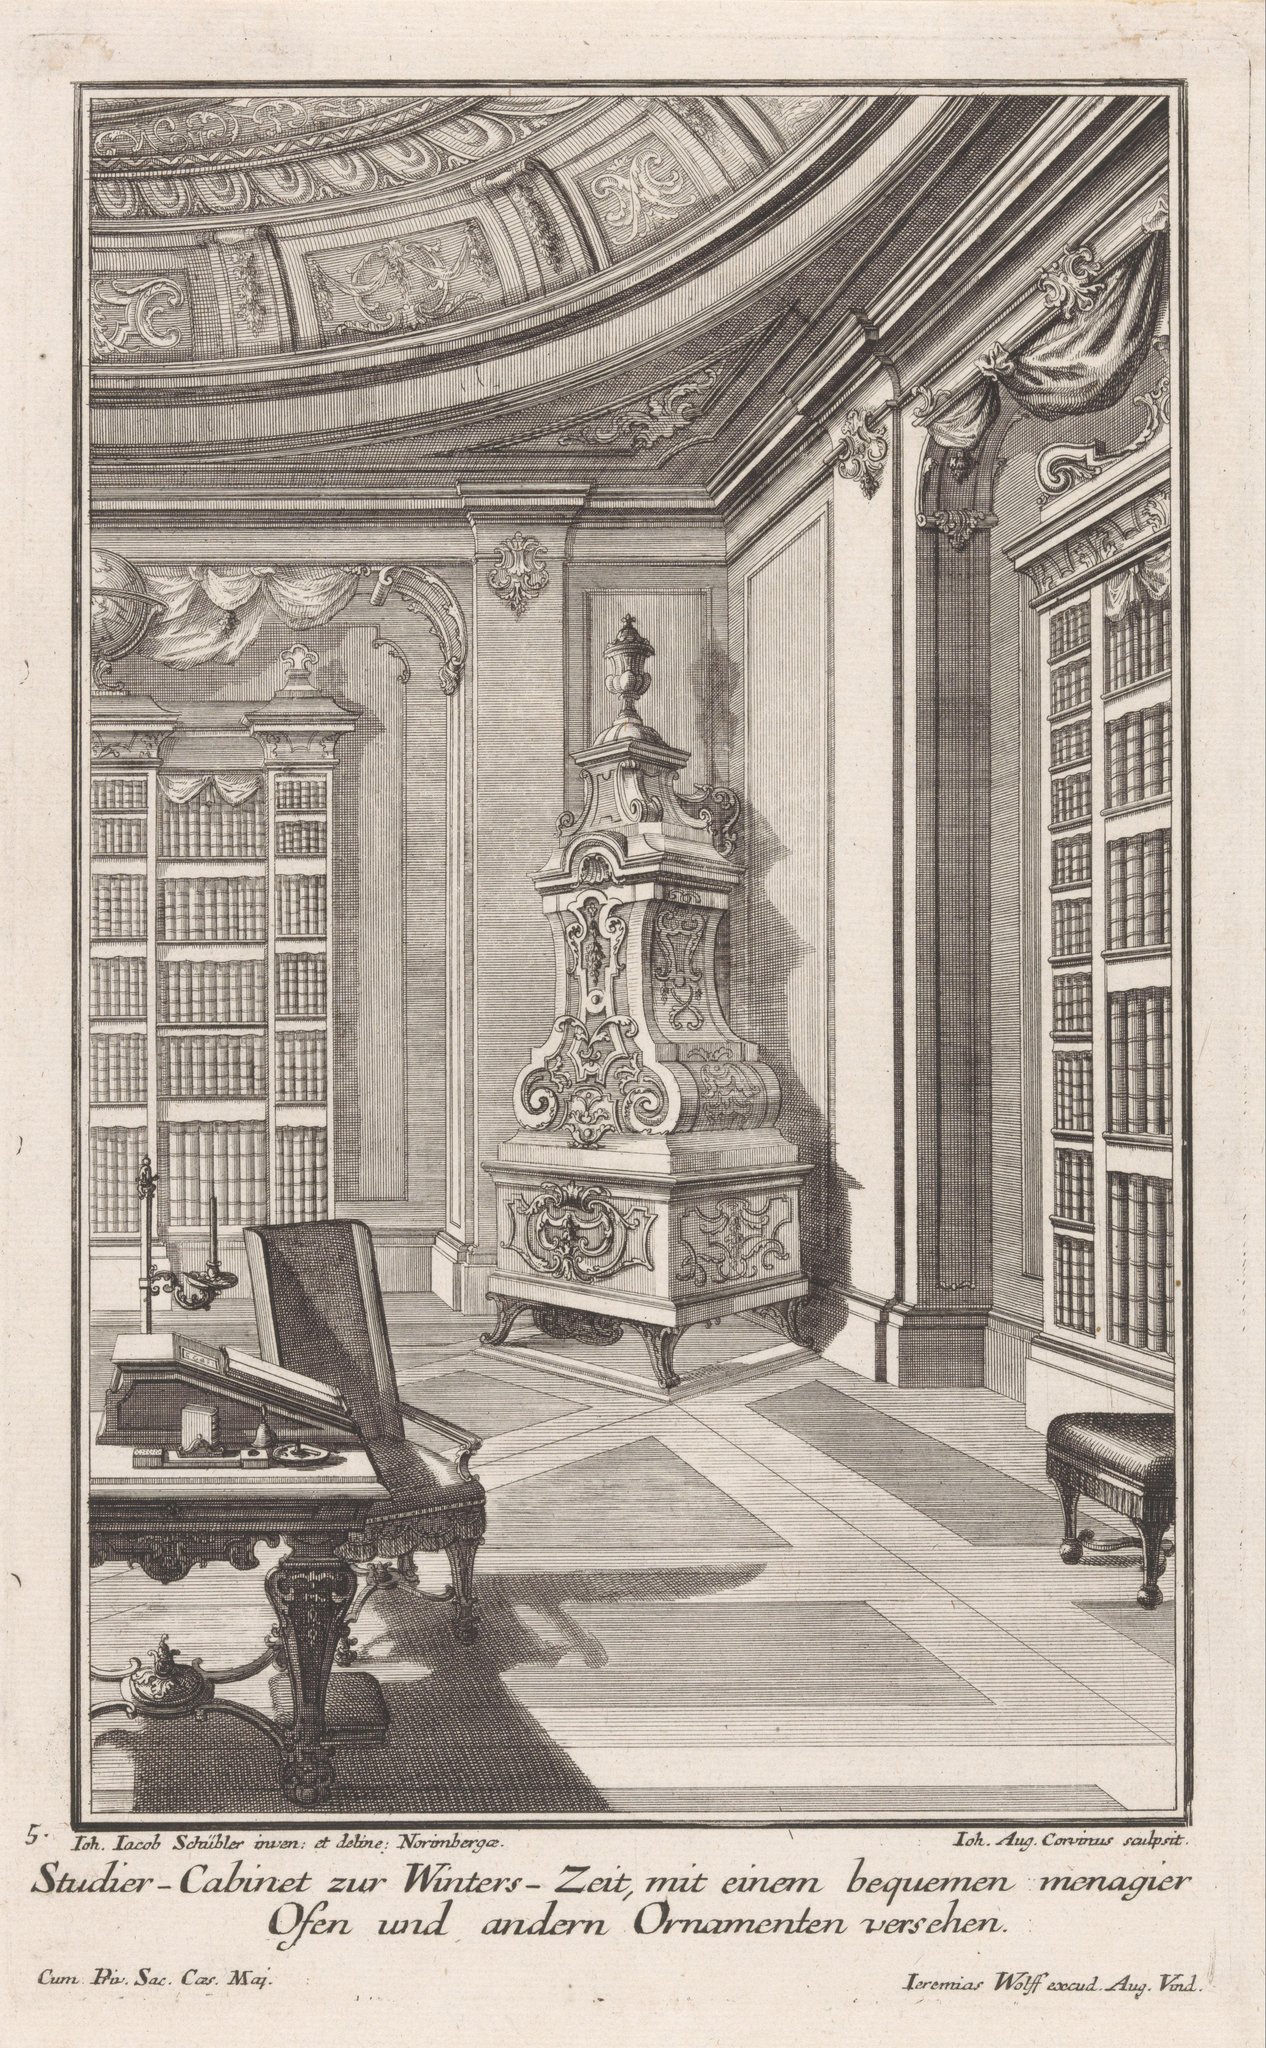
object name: print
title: Johann Jacob Schüblers Zweyte Ausgab seines vorhabenden Wercks, Vorstellend Unterschiedliche Cabinets und Alcoves (...)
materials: paper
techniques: engraving, etching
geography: augsburg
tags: writing-table, writing-desk, bookshelves, open hearth, fire-place, study; 'studiolo'; library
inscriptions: collector's mark: Lugt 2228, collector's mark: Lugt 2760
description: Prent uit: Schübler, Johann Jacob. Erste [-Zwanzigste] Ausgabe seines vorhabenden Wercks (...). Augsburg: Wolf, erven Jeremias, [na 1724]